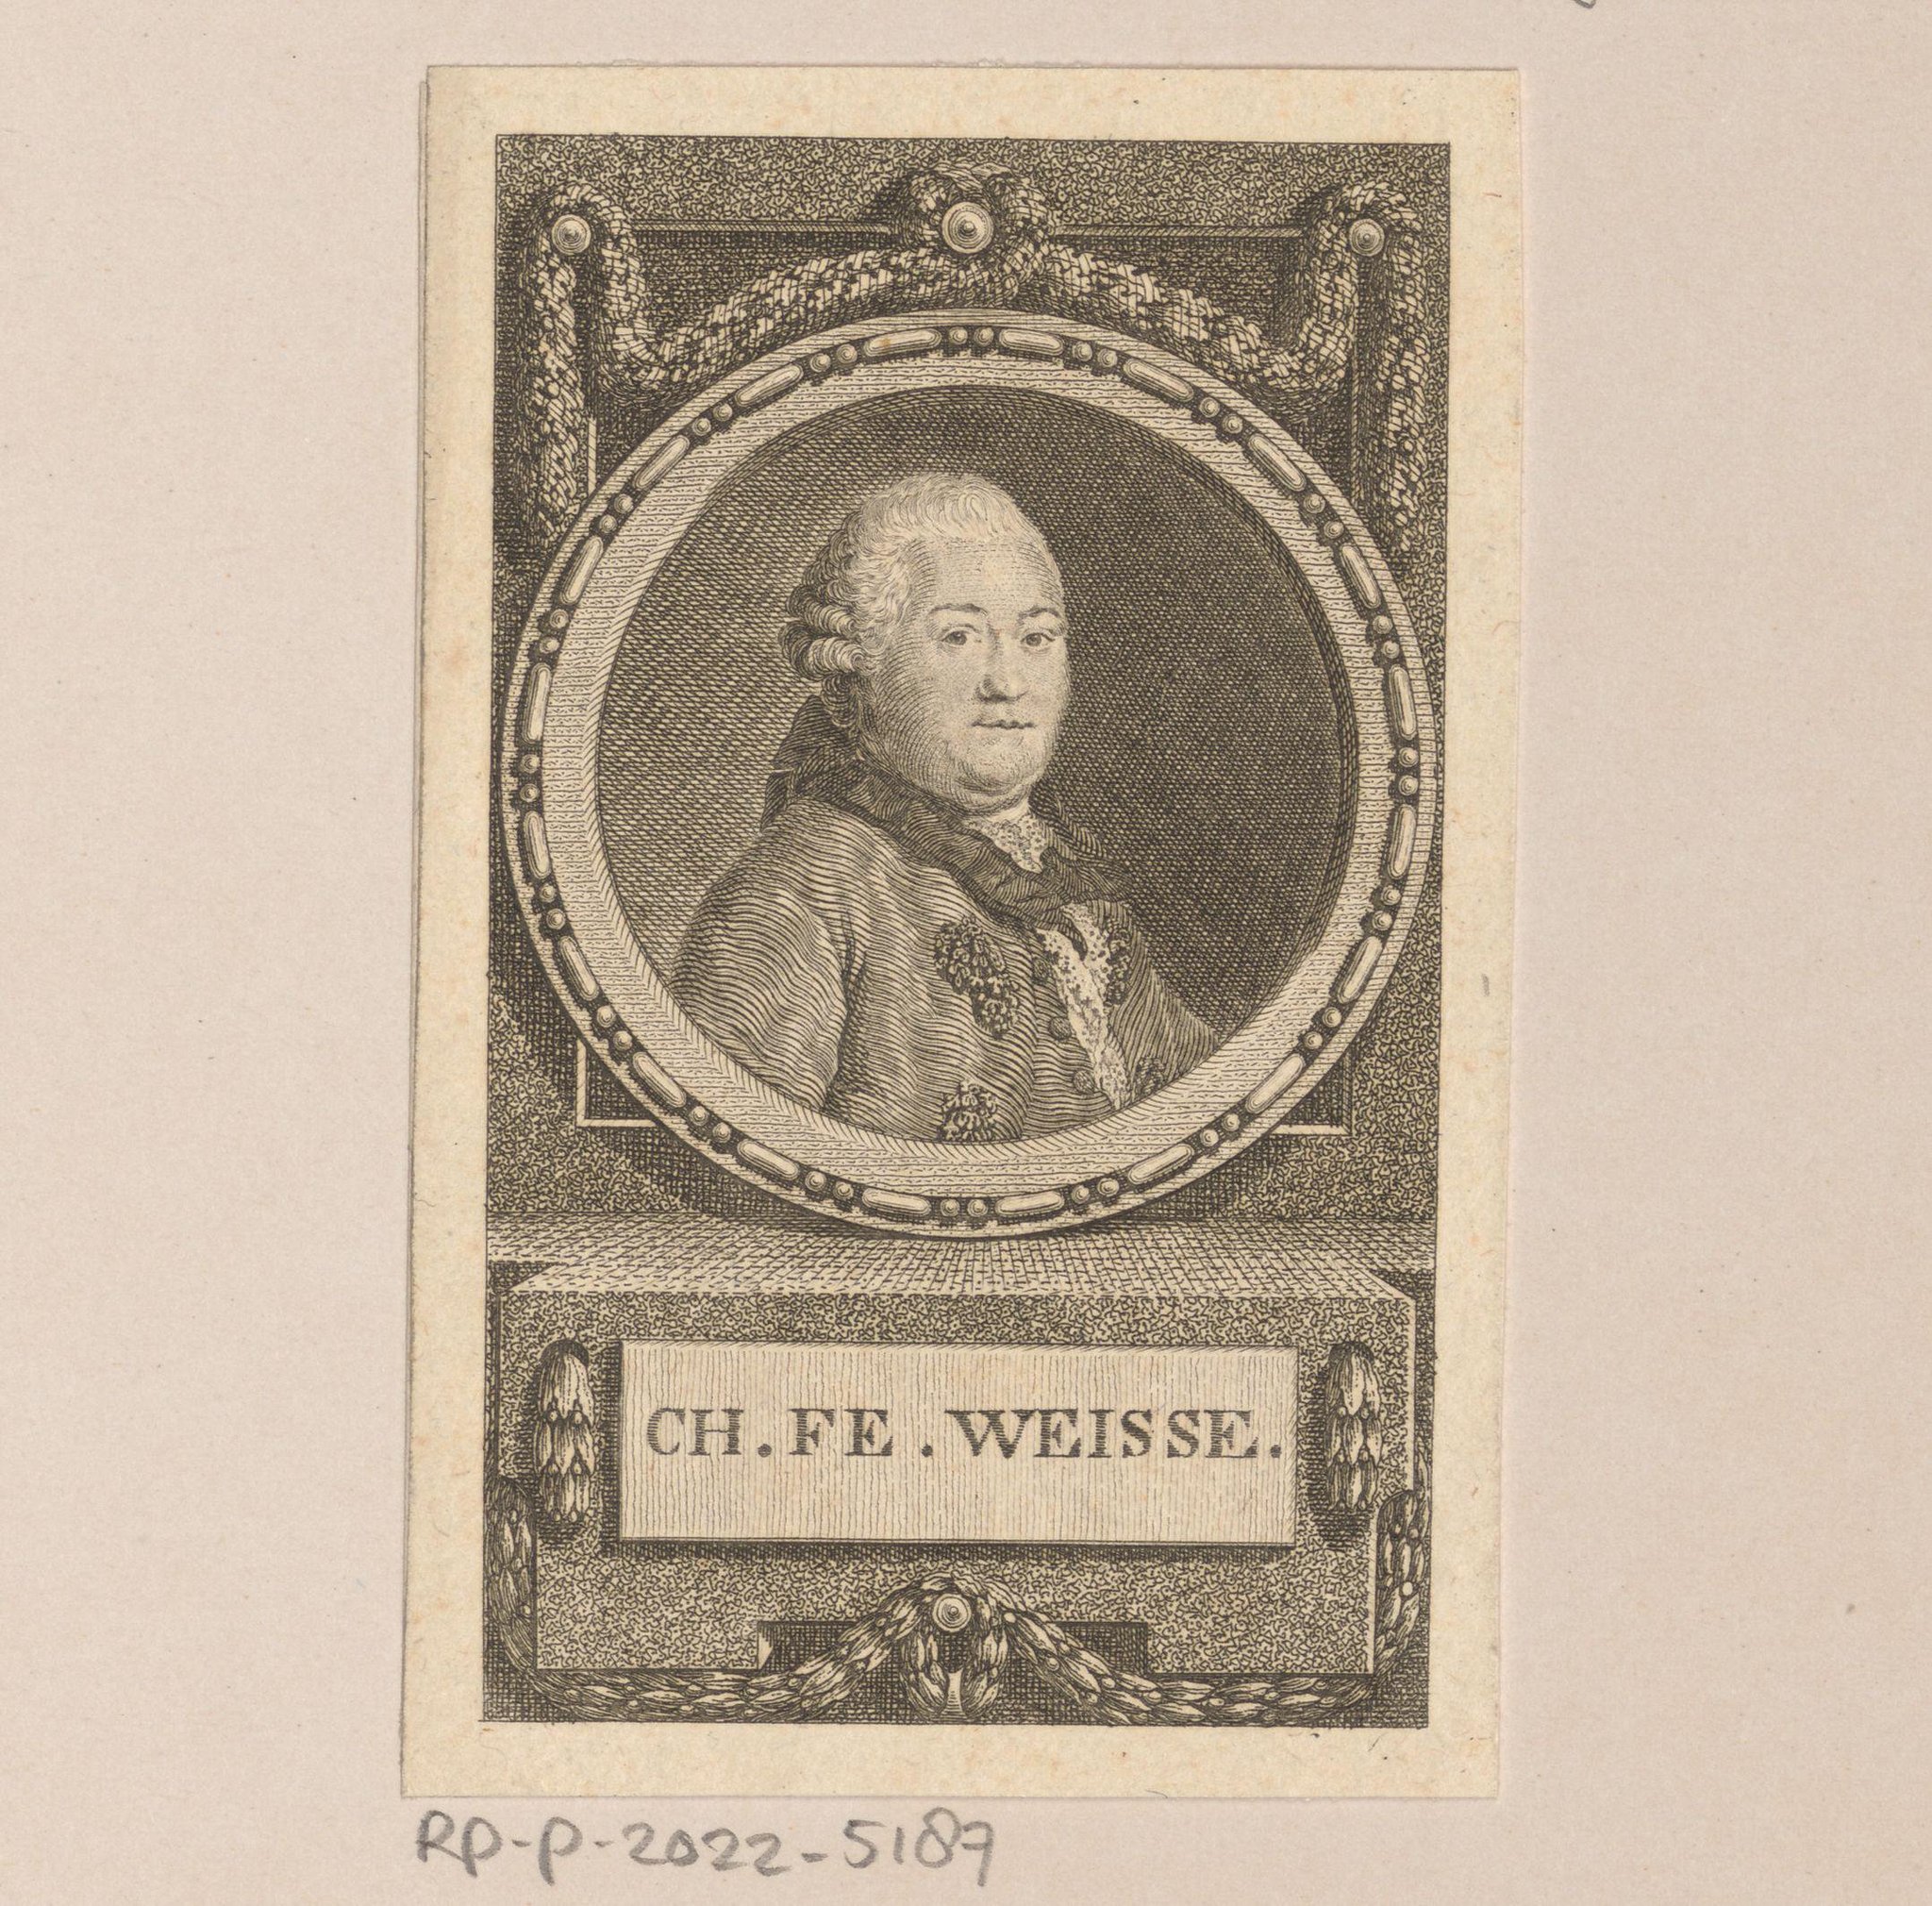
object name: print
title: Portret van Christian Felix Weisse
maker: Anonymous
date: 1760-1820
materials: paper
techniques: engraving, etching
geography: germany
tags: historical persons, writer, poet, author